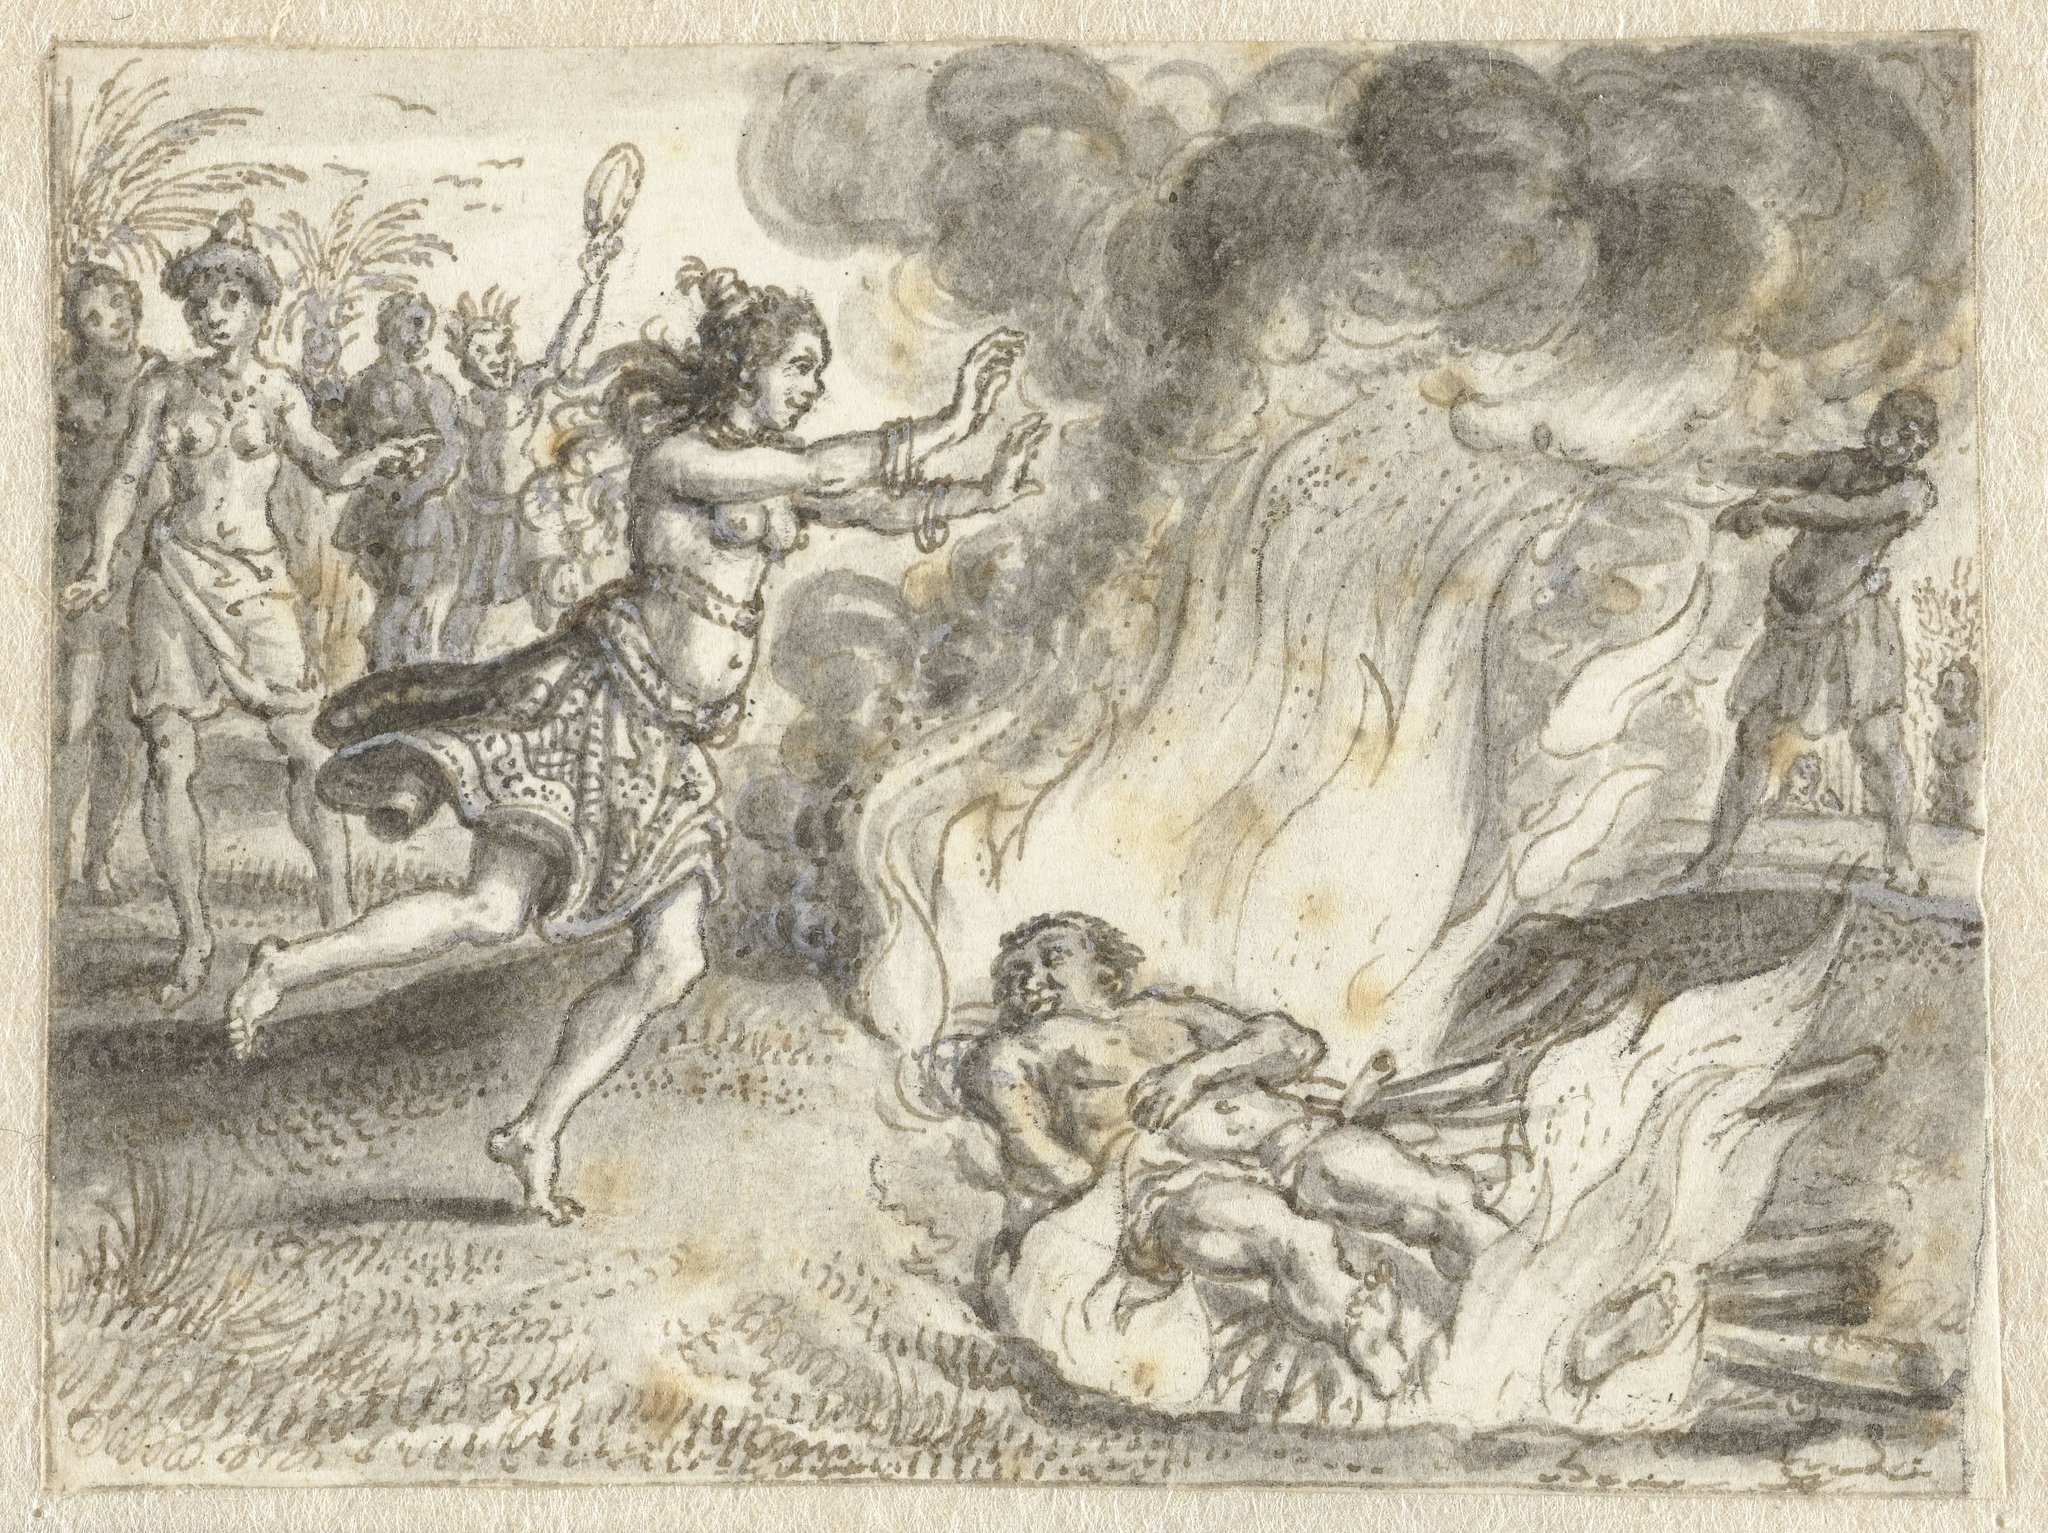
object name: design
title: Cremation as Practised by People in a Far-off Land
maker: adriaen pietersz van de venne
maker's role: draughtsman, painter, print maker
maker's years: 1589-1662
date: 1628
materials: paint, ink, paper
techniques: brush, pen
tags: (scenes from) specific works of literature (with author, title), body-burning, cremation, human races, peoples and nationalities (other than prehistoric or extinct) (+ anthropological characteristics emphasized)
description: Ontwerp voor een illustratie in Jacob Cats' 'Hovwelyck ...' van 1628: lijkverbranding bij een stam in een ver land.